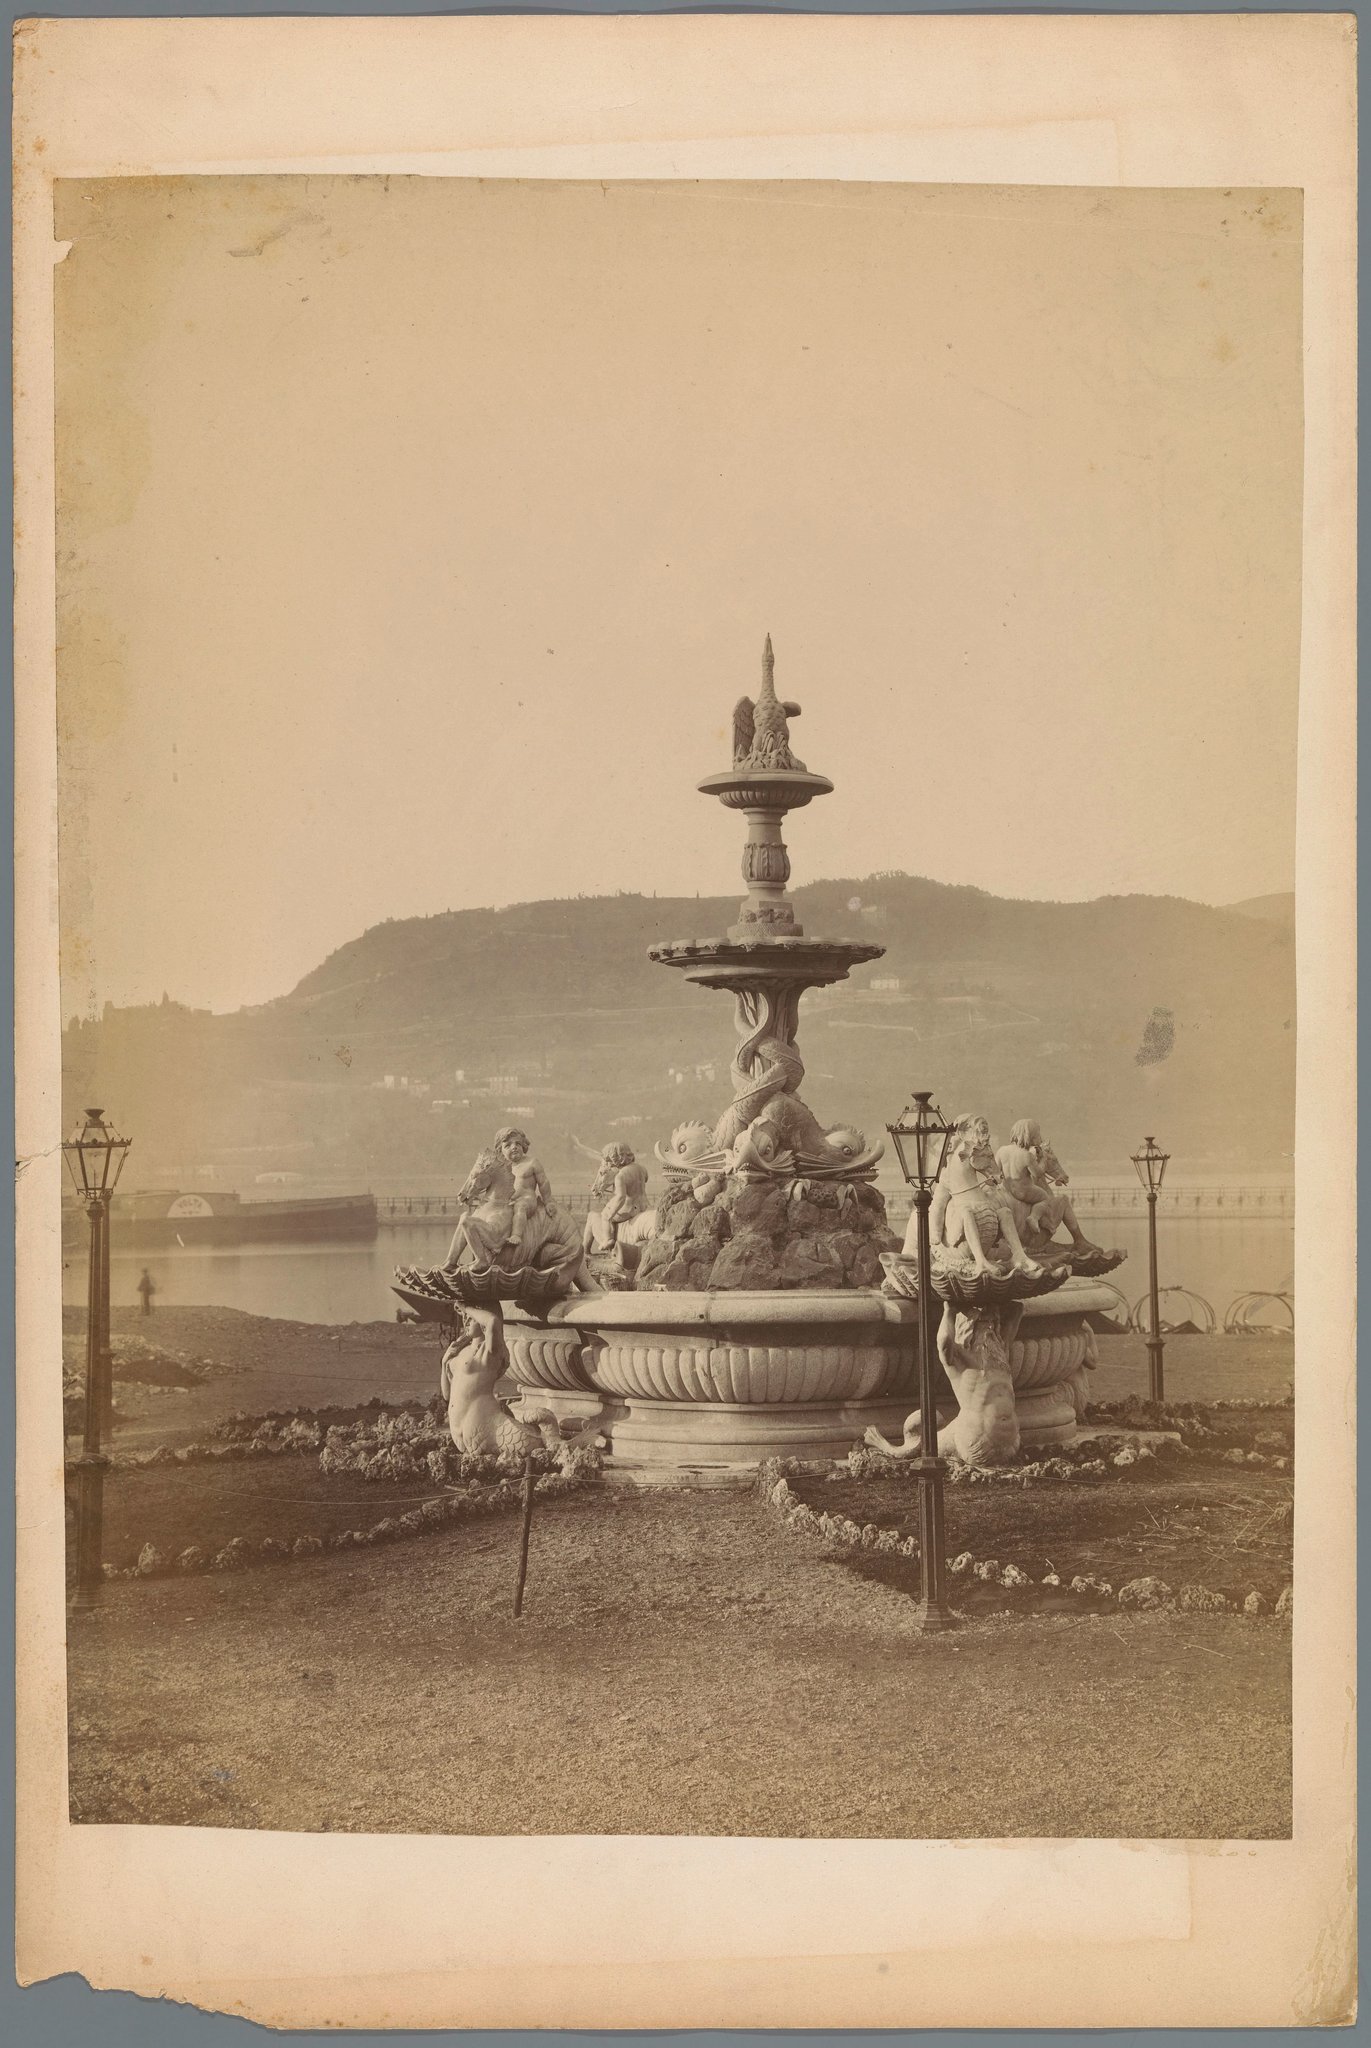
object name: photograph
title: Fontein met Nereïden, op de achtergrond een rivier en een heuvellandschap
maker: Anonymous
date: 1875-1900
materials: cardboard, photographic support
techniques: albumen print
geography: europe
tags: dolphin ~ ornament, river, other nereids (or sea-nymphs), ornamental fountain, europe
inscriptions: collector's mark: Lugt 3937